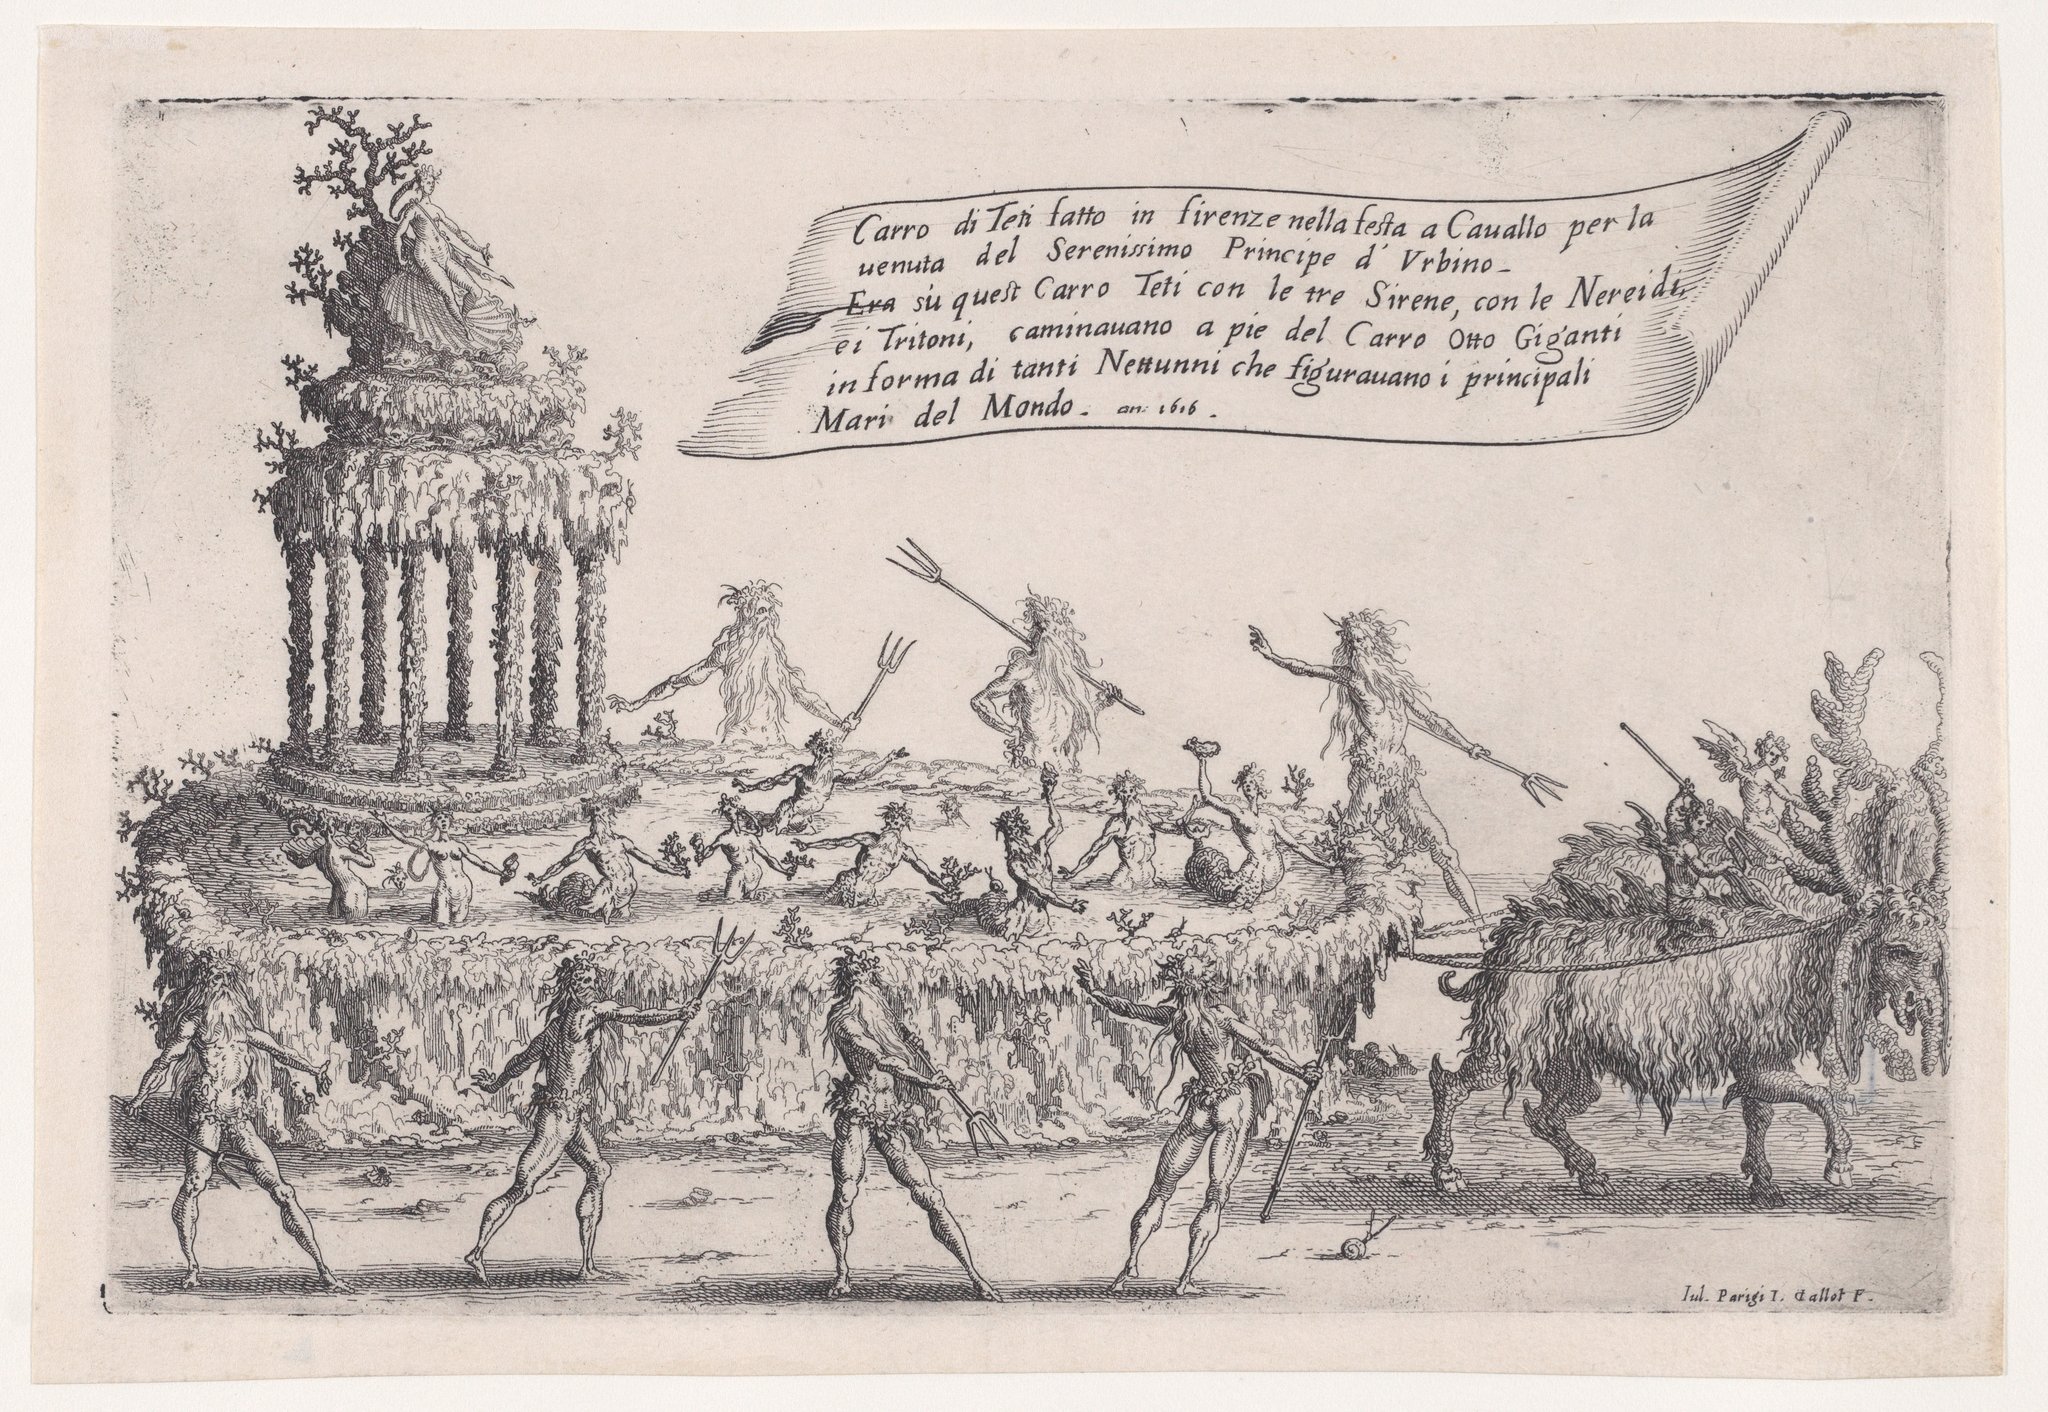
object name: print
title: Le Char de Thétis (The Chariot of Thetis), from "Guerre de Beauté" (Guerra di Bellezza) (War of Beauty)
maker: jacques callot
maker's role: artist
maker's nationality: french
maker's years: 1592-1635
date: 1616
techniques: etching